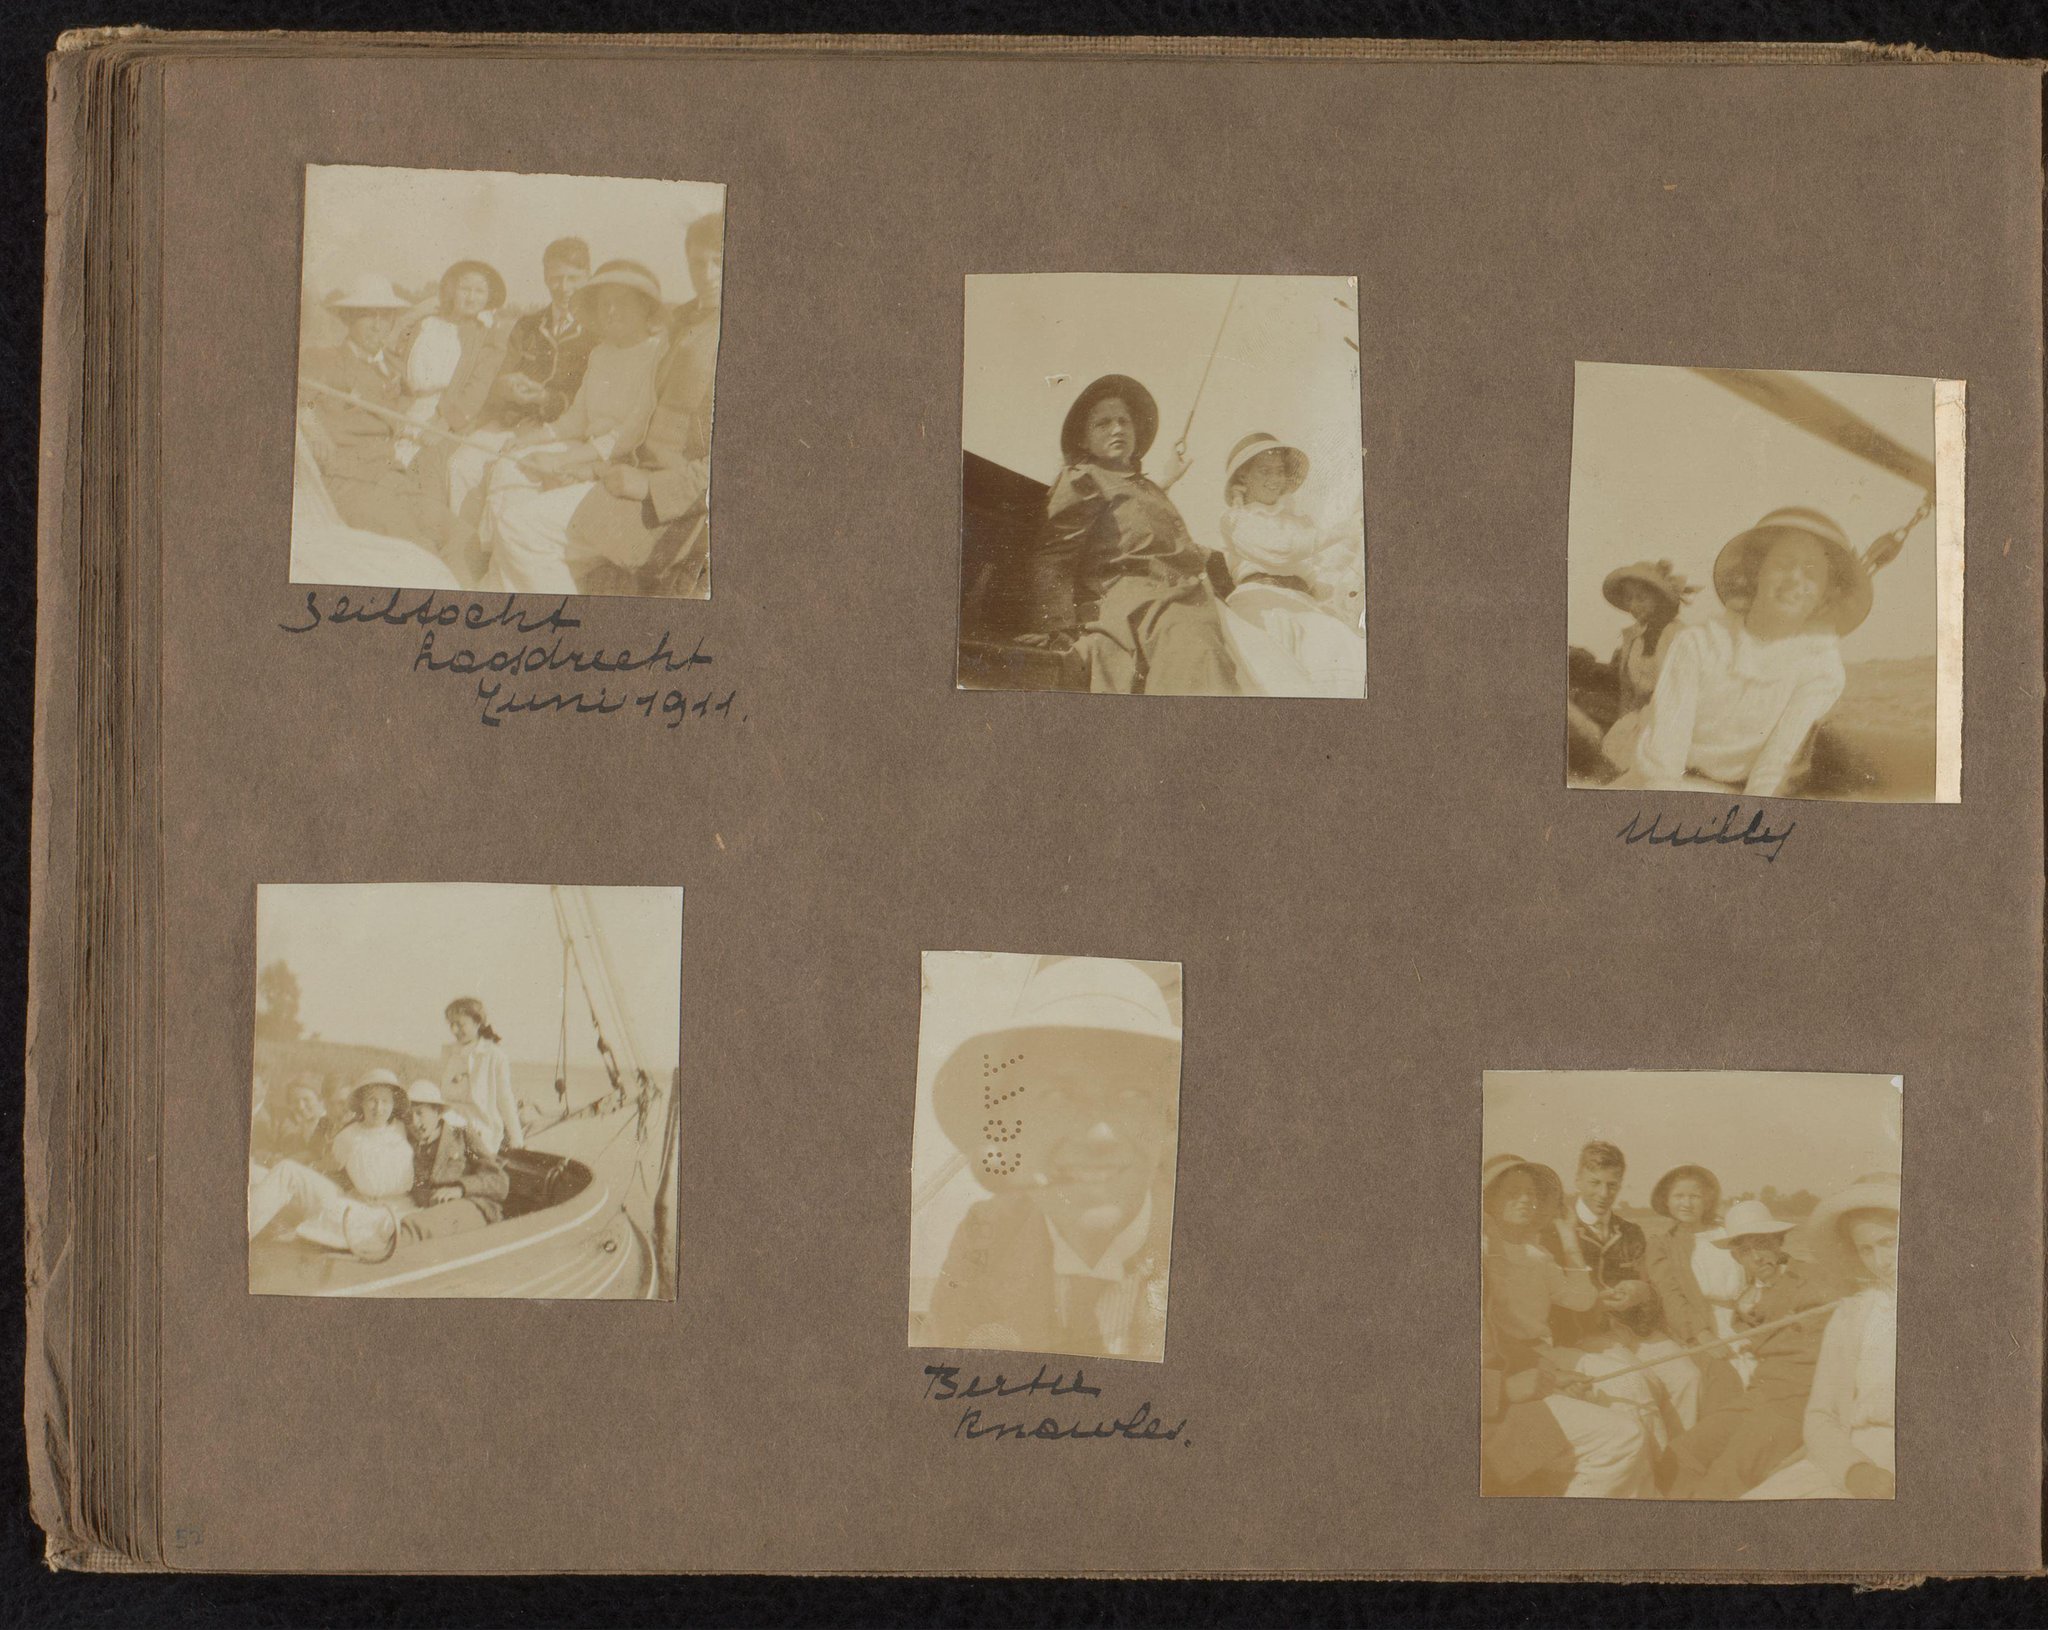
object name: photograph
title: Zes foto's van Loentje Onnen met vrienden zeilend op de Loosdrechtse Plassen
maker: carolina frederika onnen (lien/loen)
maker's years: 1896-1983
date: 1906-1911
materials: paper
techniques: gelatin silver print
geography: loosdrechtse plassen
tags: amsterdam, carolina frederika onnen (lien/loen), sailing-ship, sailing-boat, historical persons, friends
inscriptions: inscription: ‘Bertie/ Knowles’, inscription: ‘Zeiltocht/ Loosdrecht/ Juni 1911.’, inscription: ‘Milly’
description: Deze foto's maken deel uit van een album.